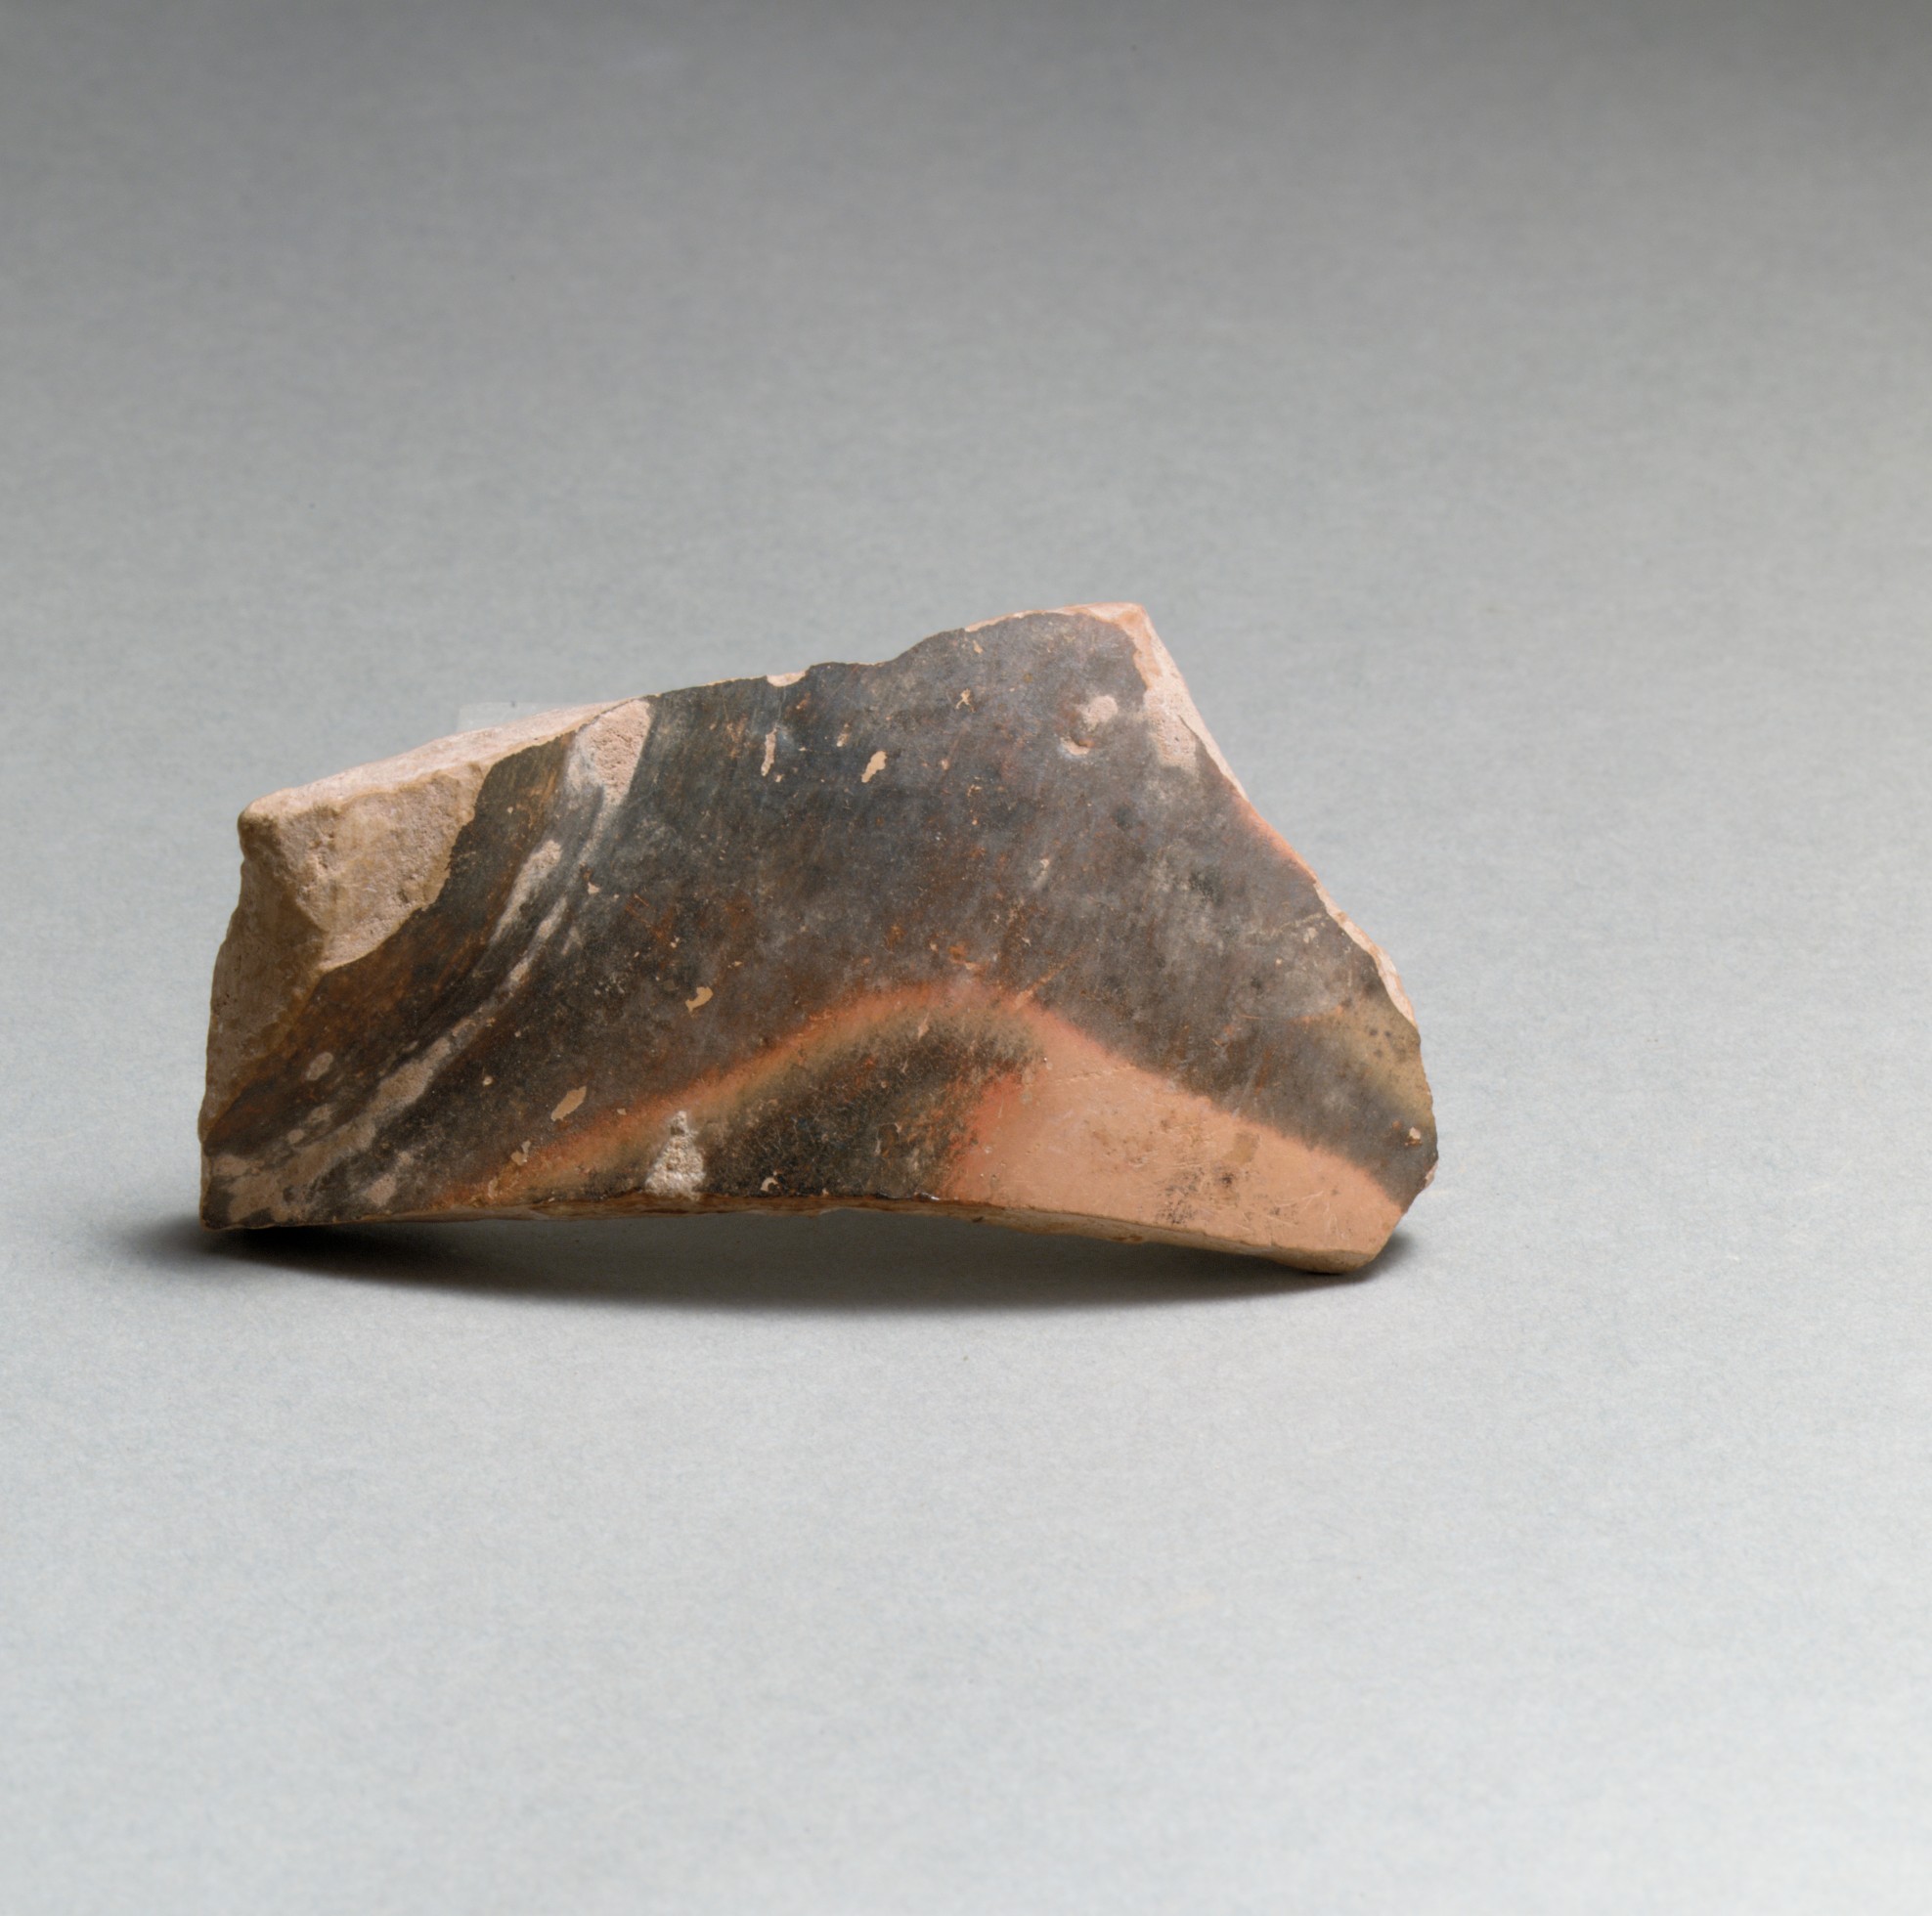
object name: vase fragment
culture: minoan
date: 2600-2000 BCE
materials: terracotta